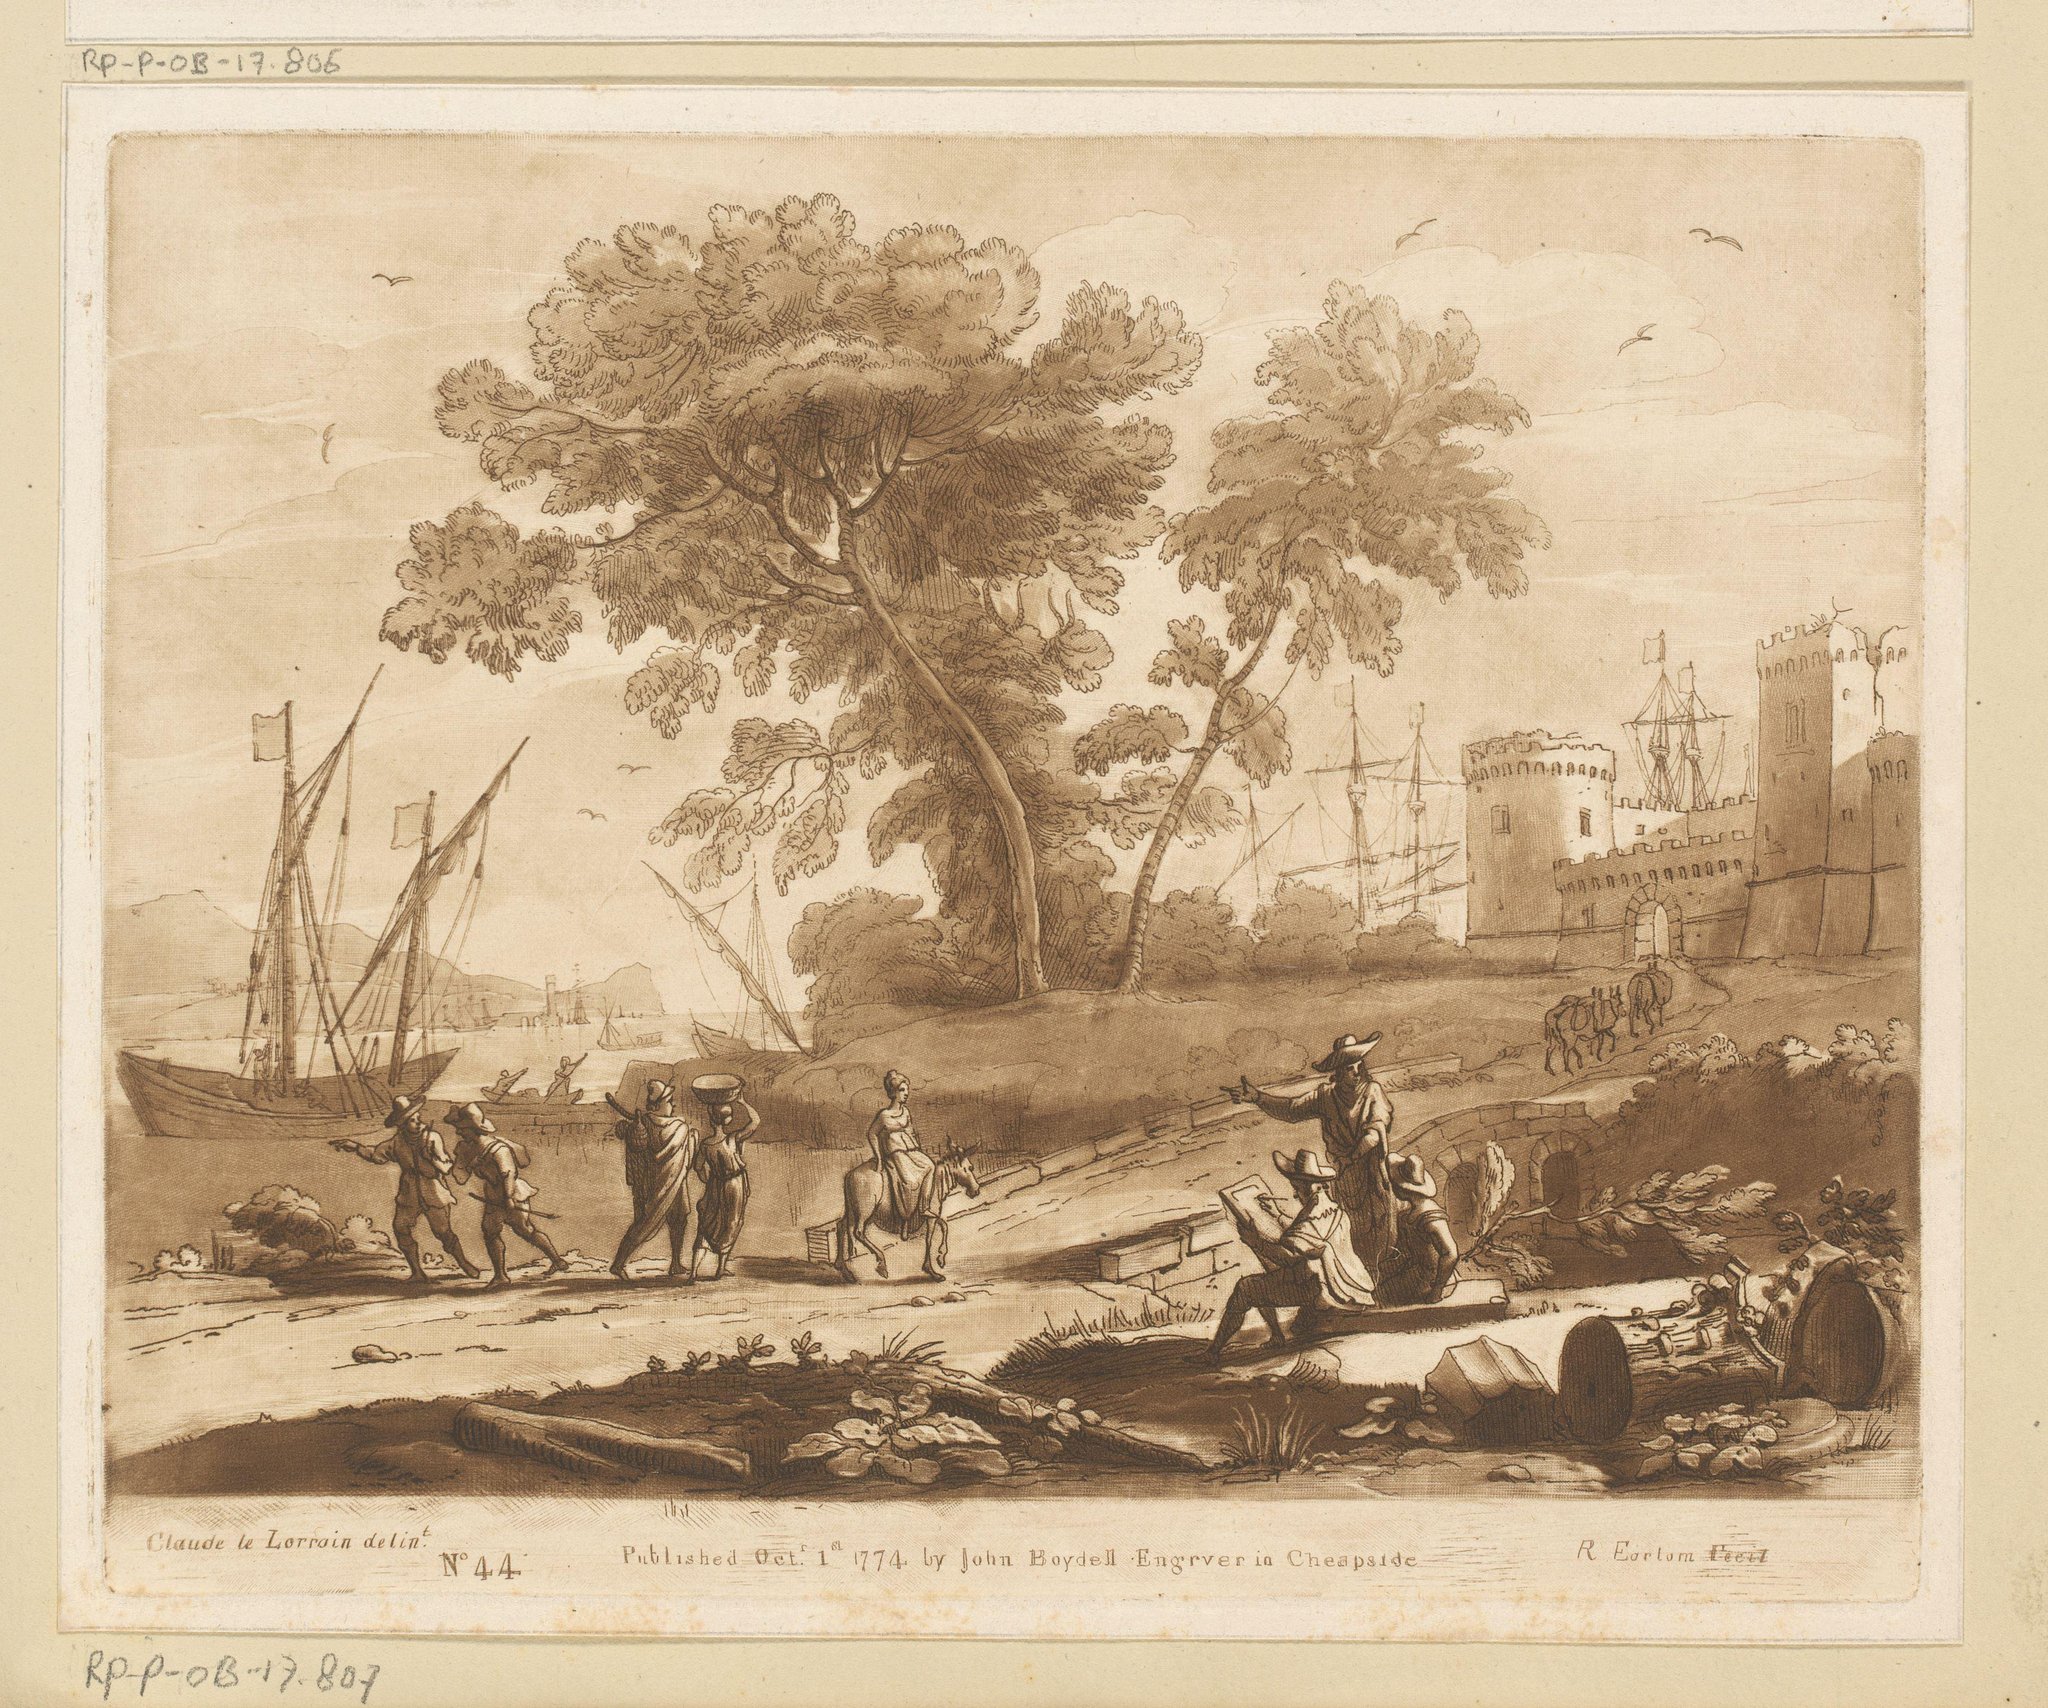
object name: print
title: Prenten naar tekeningen van Claude Lorrain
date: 1774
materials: paper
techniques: etching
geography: london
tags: castle, draughtsman at work - cc - out of doors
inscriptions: date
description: Vanaf 1774 publiceerde John Boydell tweehonderd prenten naar het tekeningenboek Liber Veritatis van Claude Lorrain, in het bezit van de hertogen van Cavendish. Deze prenten werden vanaf 1777 in twee volumes gebundeld uitgegeven.